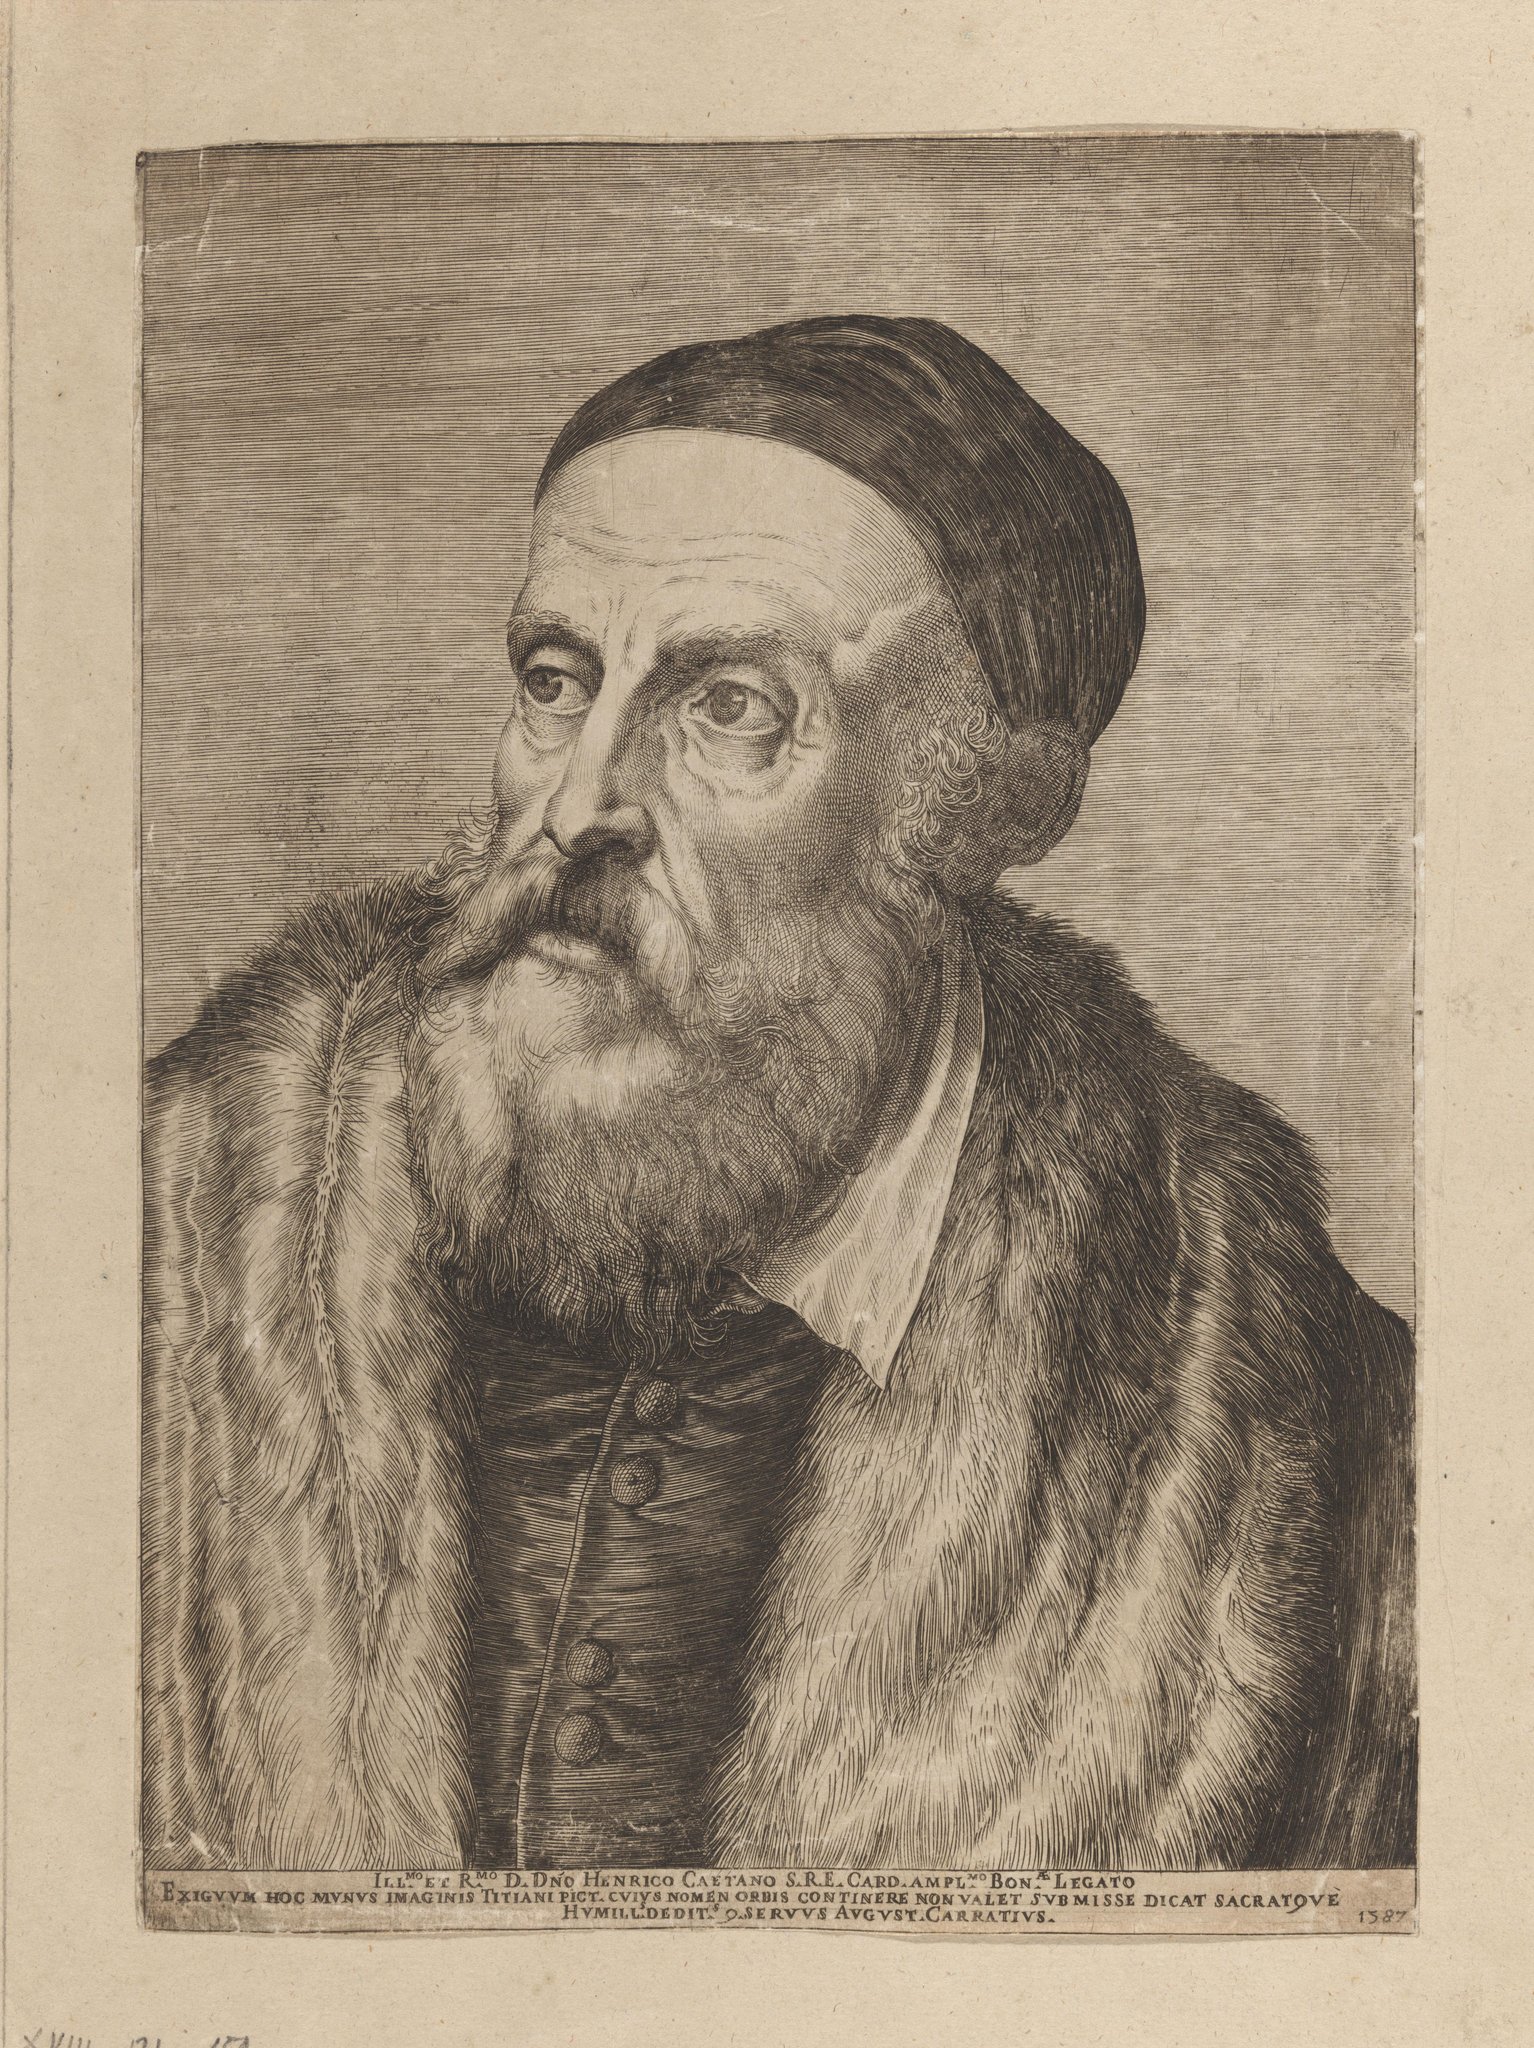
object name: print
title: Portret van schilder Titiaan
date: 1587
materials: paper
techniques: engraving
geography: bologna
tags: venice, titiaan, historical persons, portrait, self-portrait of artist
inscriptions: date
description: Naar geschilderd zelfportret van Titiaan in de Staatliche Museen Preussischer Kulturbesitz, Gemäldegalerie te Berlijn.